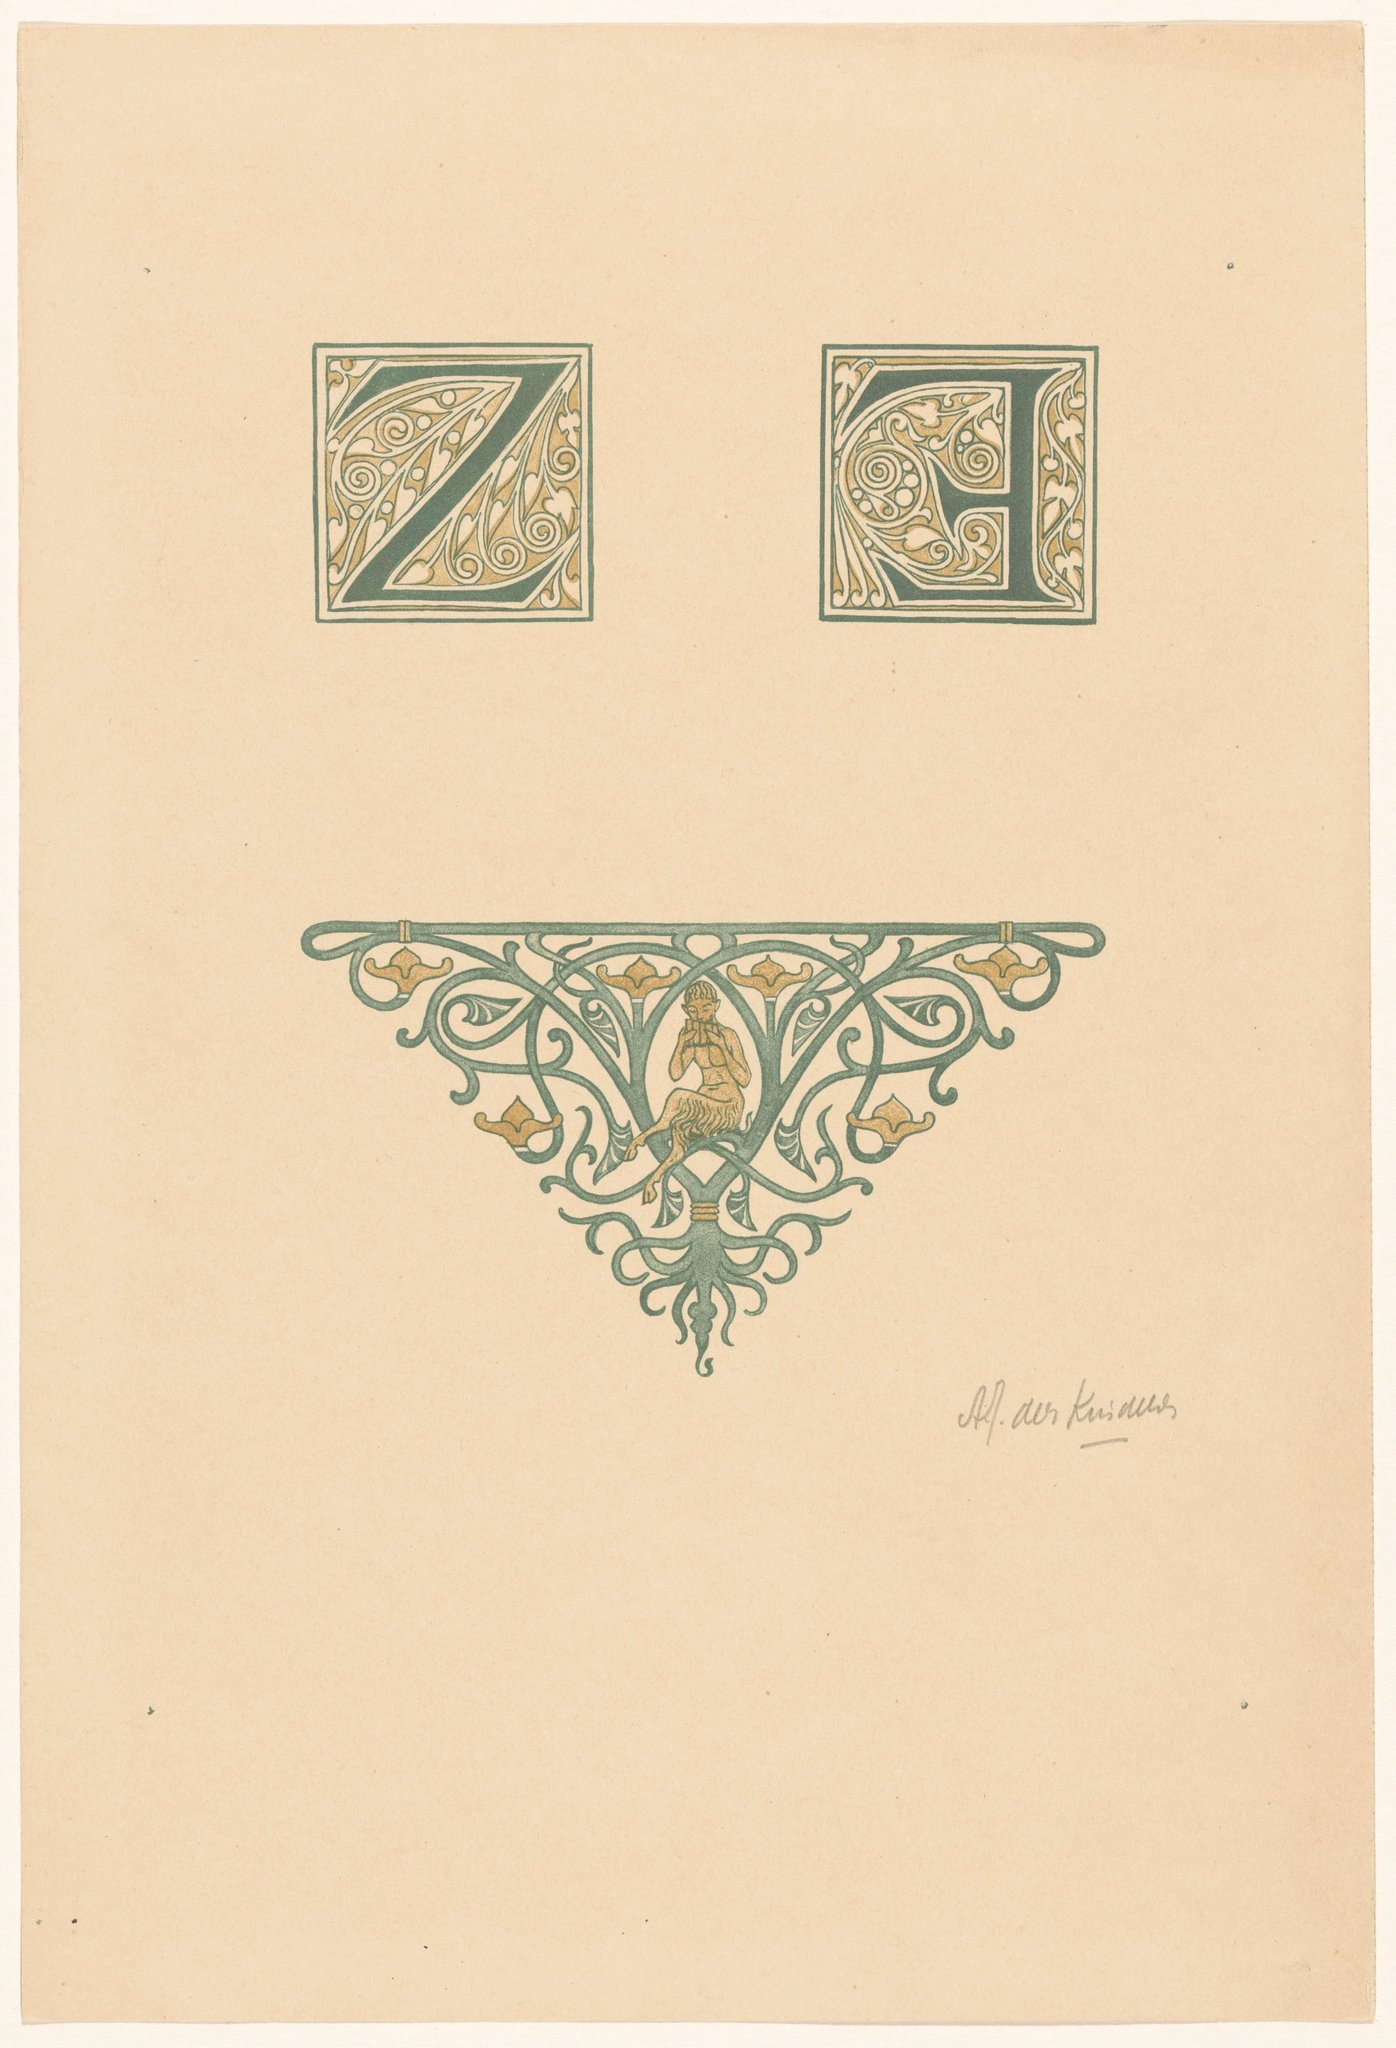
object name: print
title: Hoofdletters E en Z en vignet met sater en panfluit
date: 1896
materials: paper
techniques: lithograph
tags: initial, satyr(s) (in general)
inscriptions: collector's mark: Lugt 2233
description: De hoofdletters zijn omgeven door een vierkant kader. De restvormen zijn ingevuld met plantmotieven. Onder de hoofdletters een driehoekig vignet versierd met plantmotieven en in het midden een sater die een panfluit bespeelt.